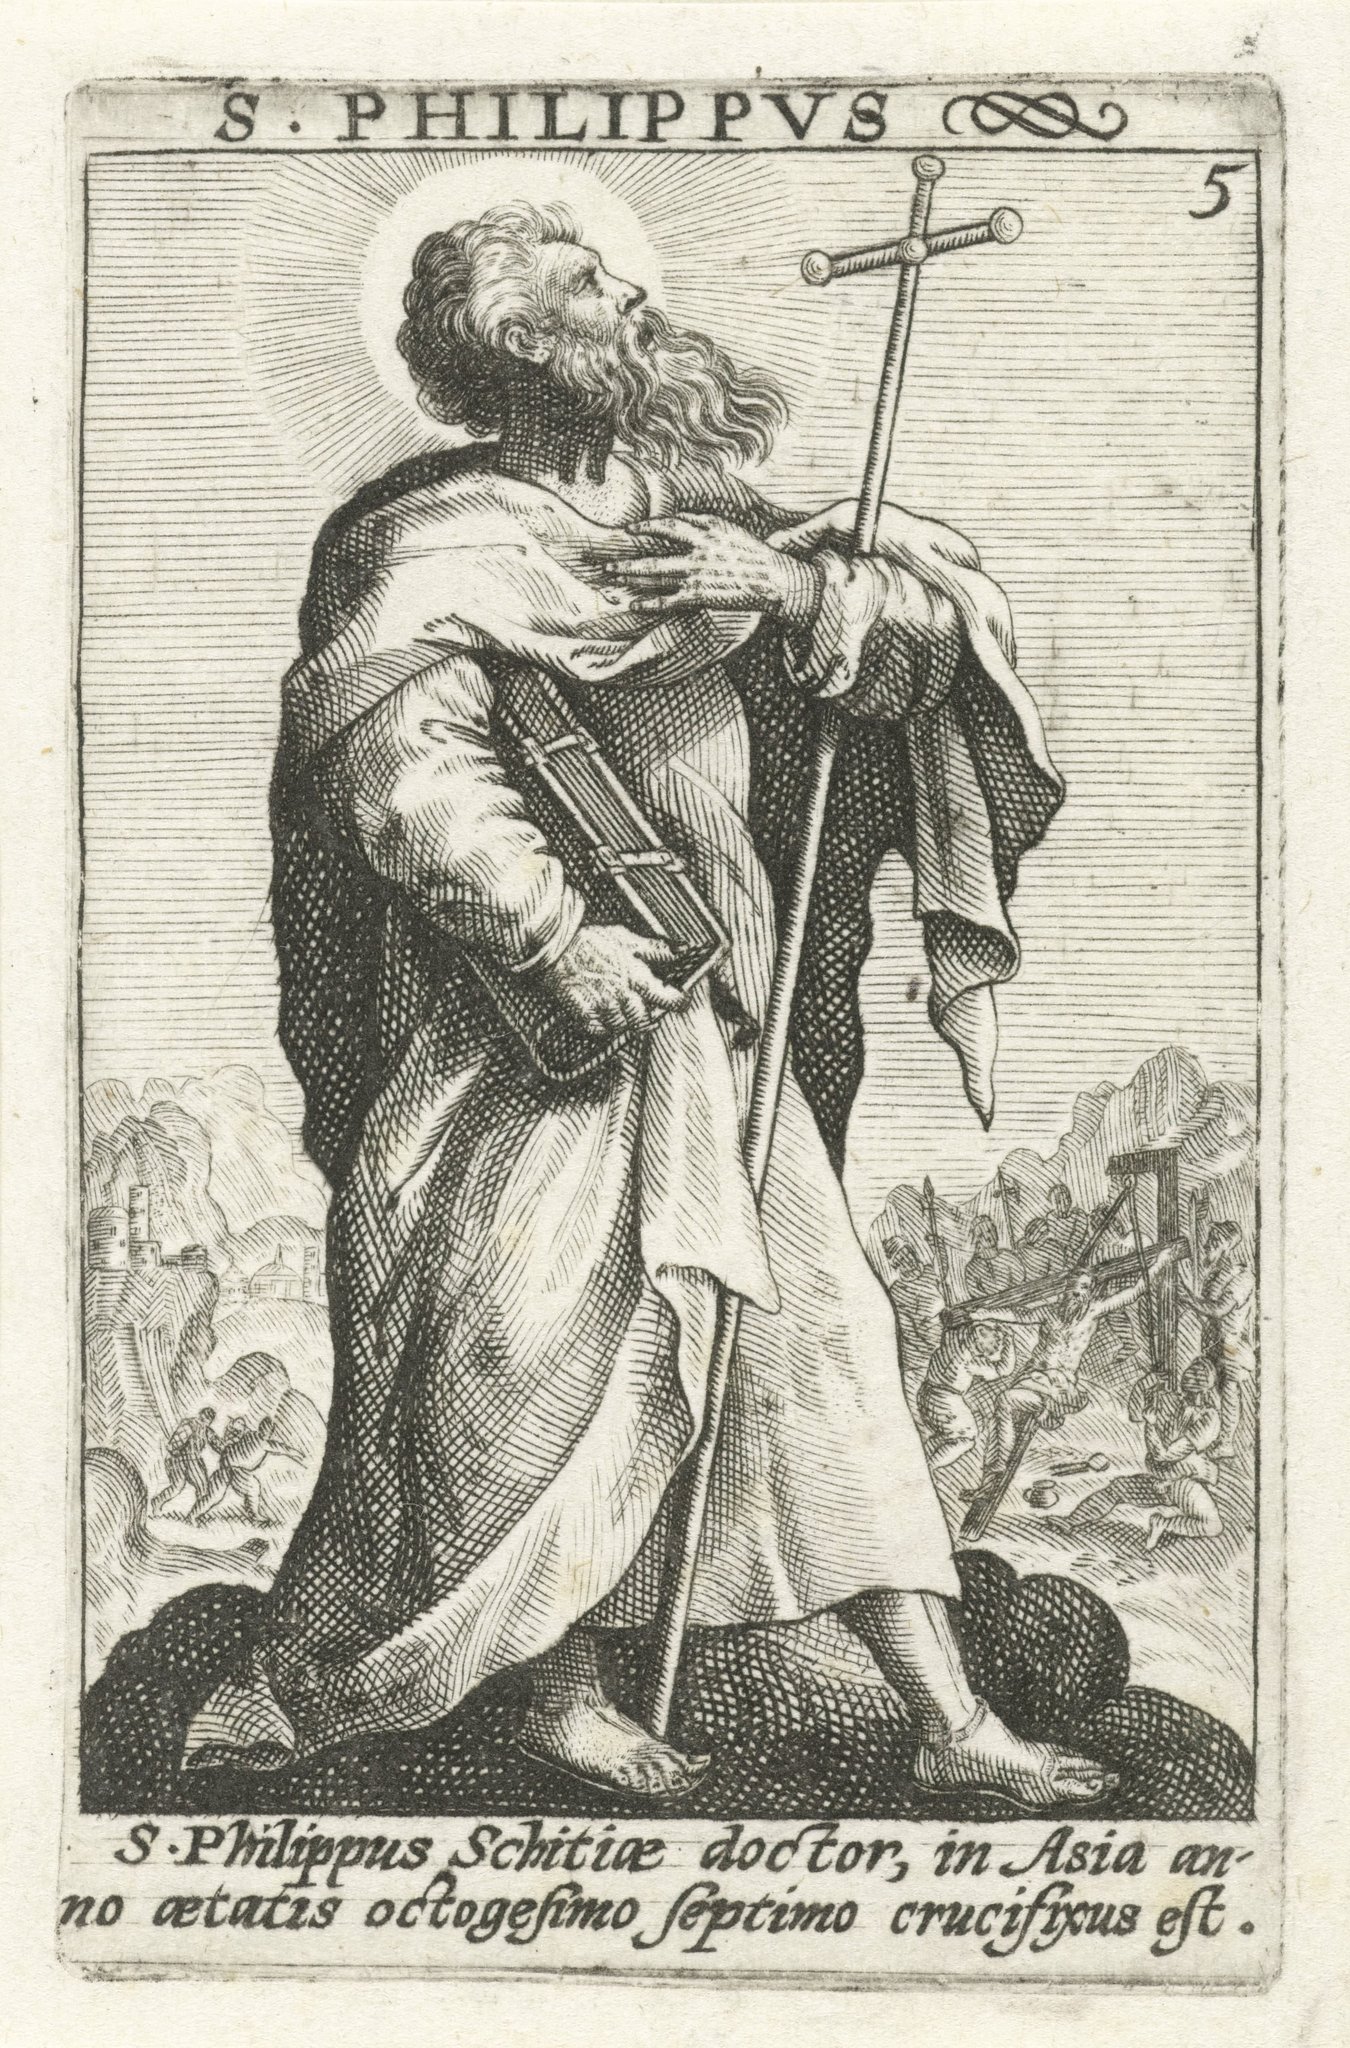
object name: print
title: S. Philippvs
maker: crispijn van de passe (i)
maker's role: draughtsman, print maker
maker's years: 1564-1637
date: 1574-1637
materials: paper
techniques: engraving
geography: cologne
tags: the apostle philip; possible attributes: book, cross, dish with snake, lance, scroll, stone, sword, philip is crucified (sometimes upside down)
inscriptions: collector's mark: Lugt 240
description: De apostel Filippus, ten voeten uit, een kruisstaf en een boek in zijn handen. Op de achtergrond zijn kruisiging. In de marge een onderschrift in het Latijn. Prent uit een serie met de twaalf apostelen.